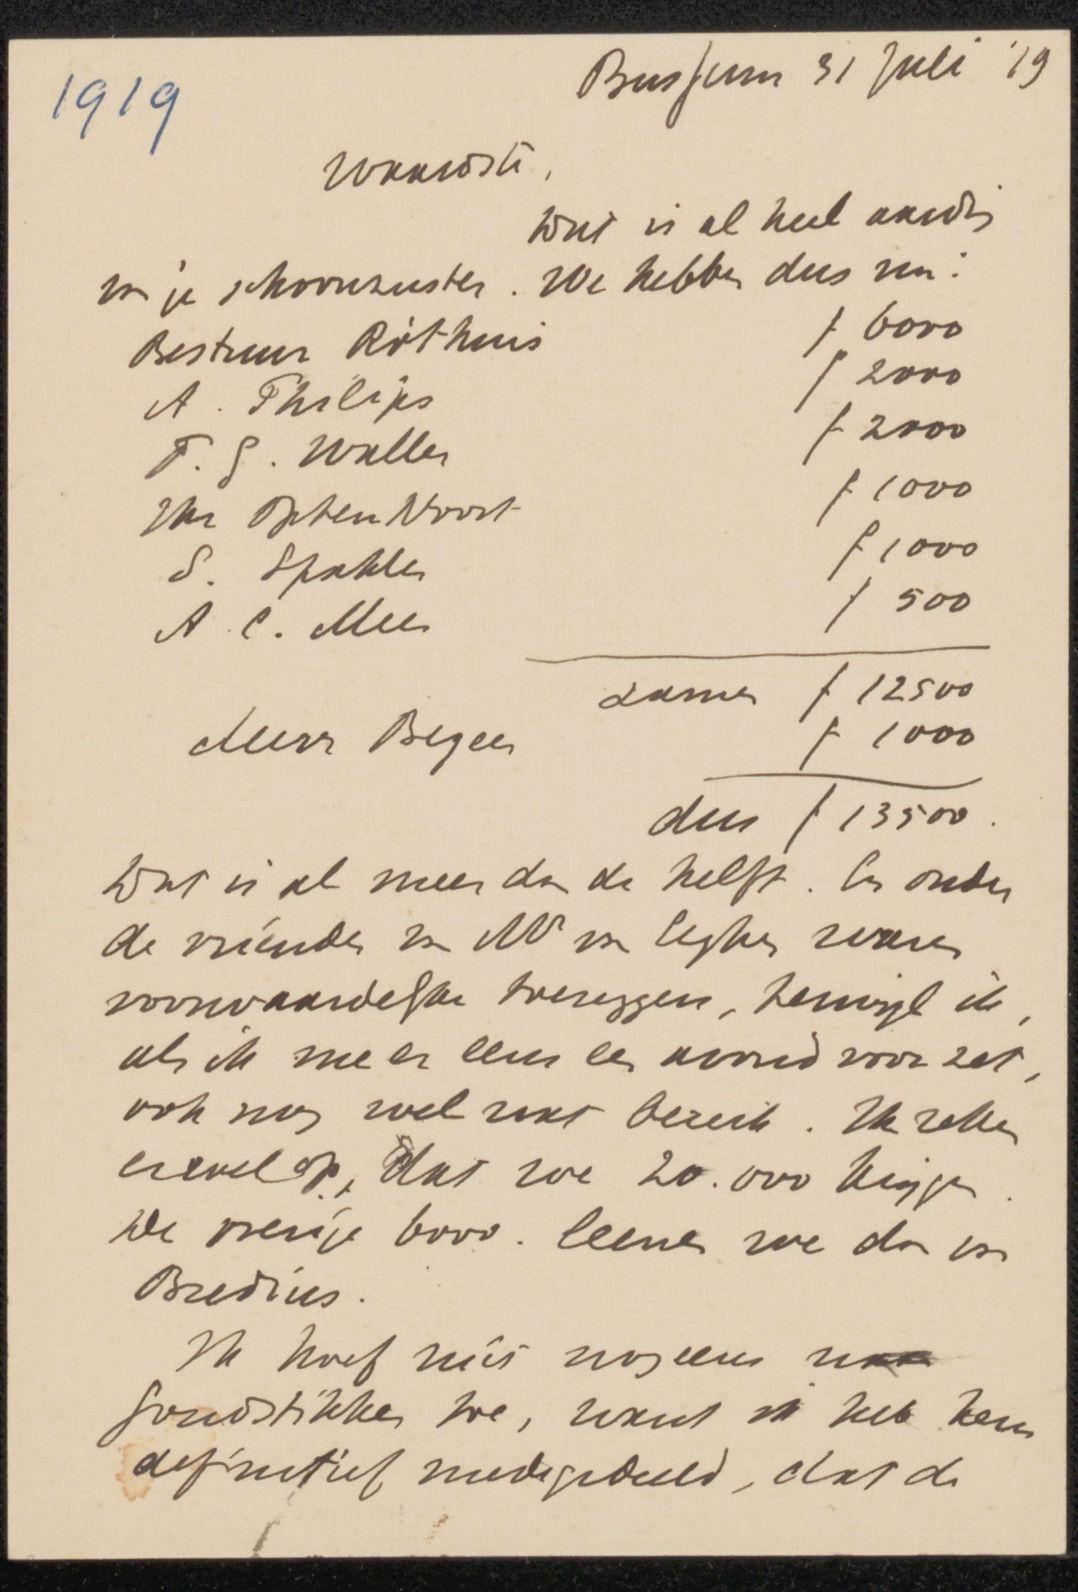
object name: letter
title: Brief aan Cornelis Gerardus 't Hooft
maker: jan veth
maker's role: designer, draughtsman, painter, print maker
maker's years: 1864-1925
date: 1919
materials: cardboard, ink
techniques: pen, writing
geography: bussum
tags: abraham bredius, dordrecht, amsterdam, painter, draughtsman, cornelis gerardus 't hooft, paris, mozes isaac duparc, drawing, art collecting, money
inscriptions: collector's mark: ‘RPK’